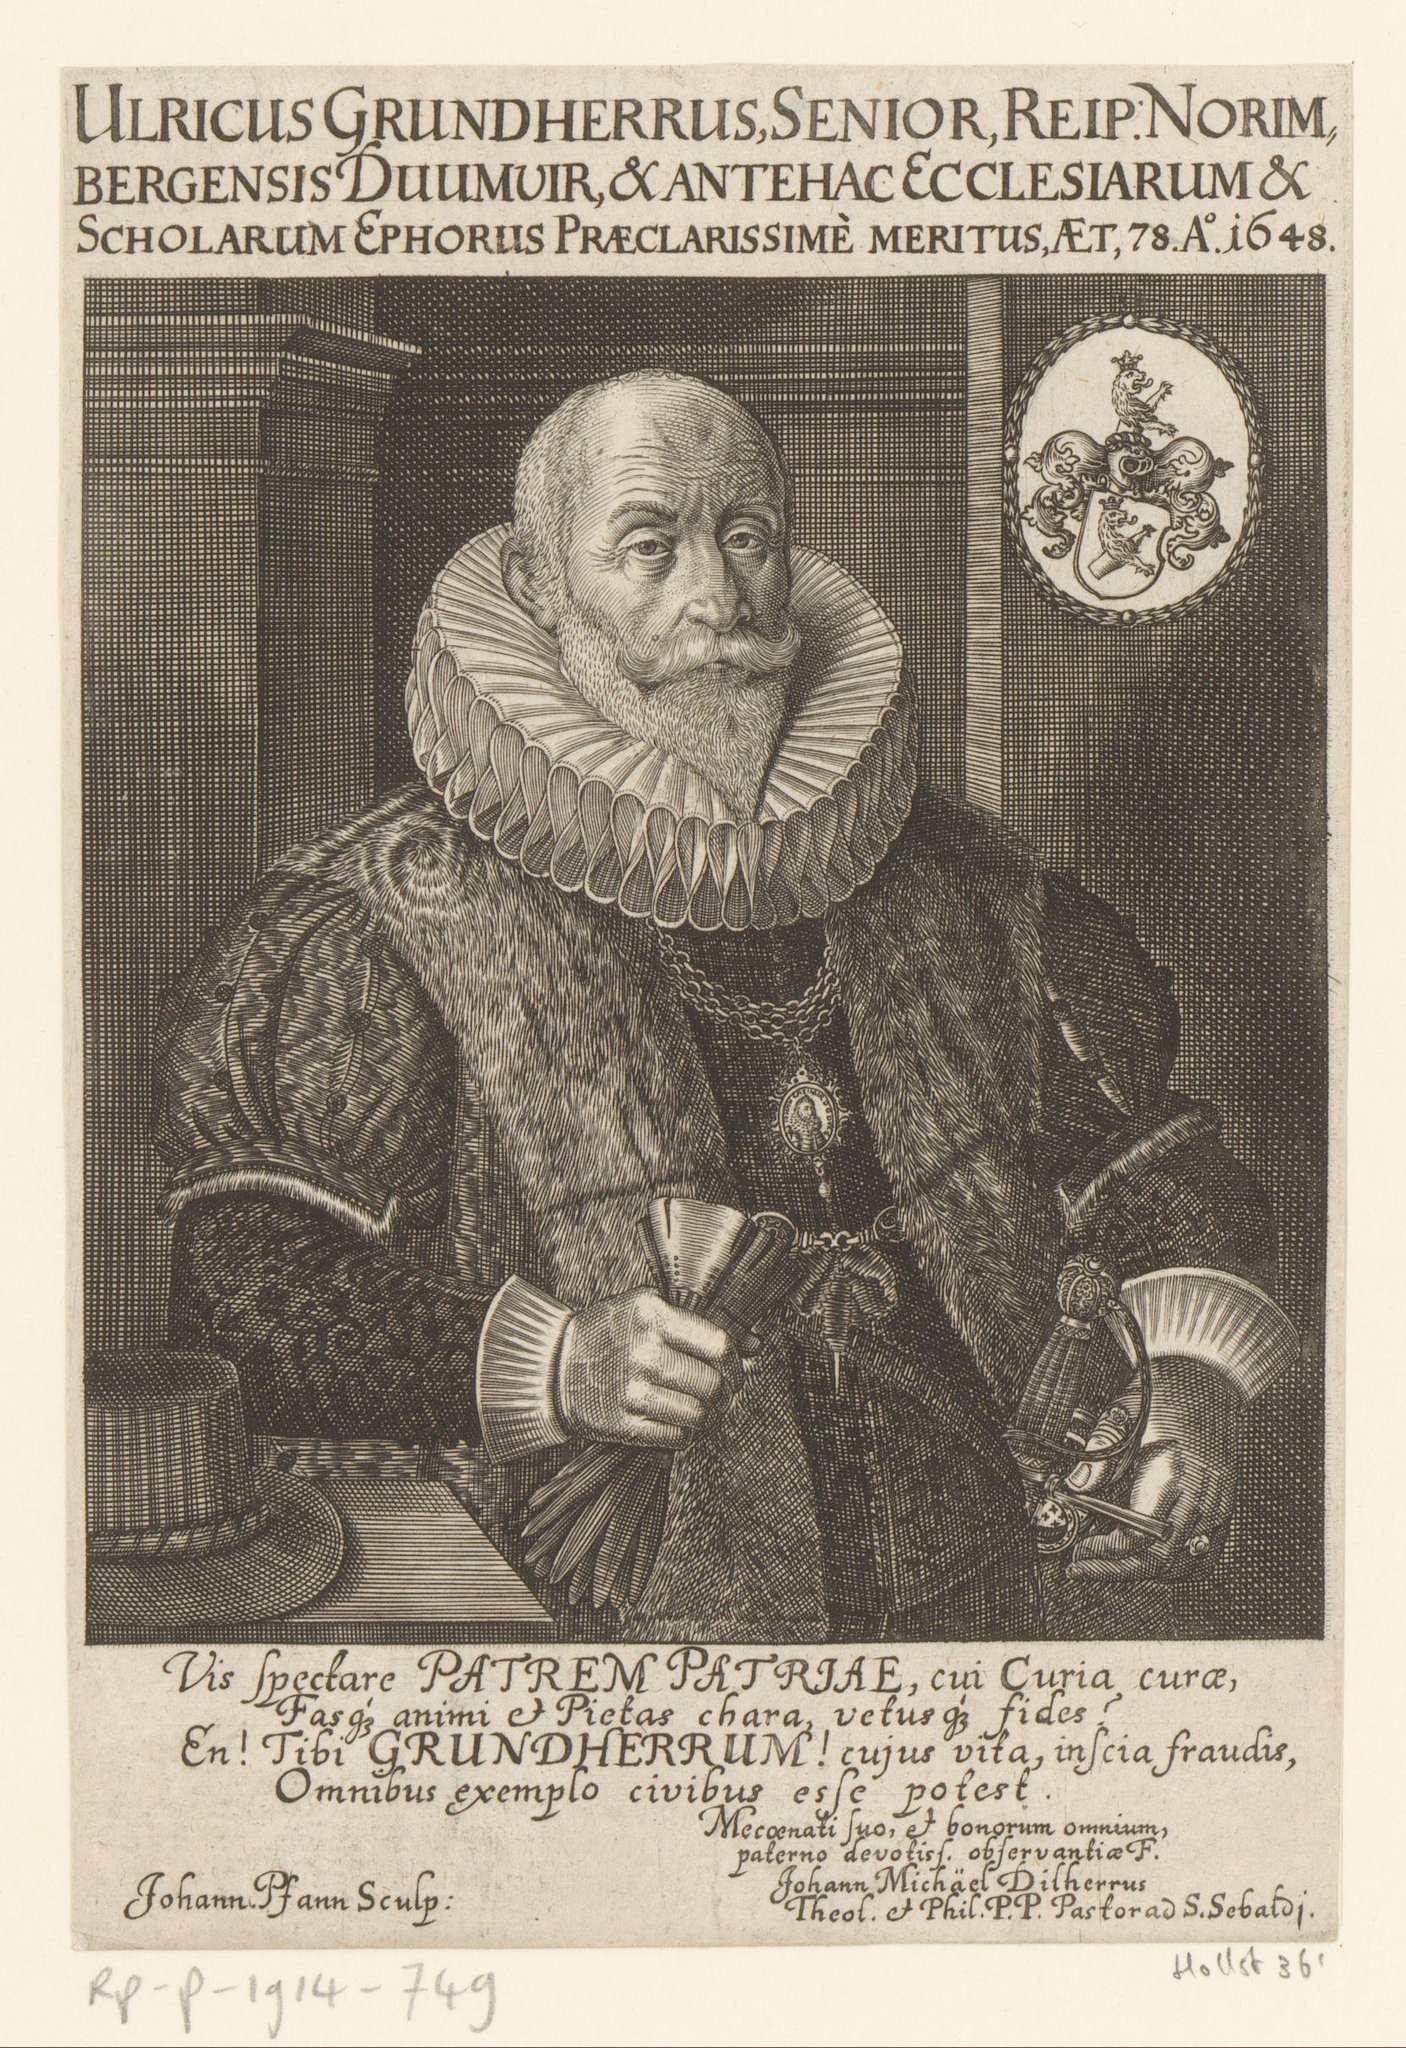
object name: print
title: Portret van Ulric Grundherr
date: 1648-1663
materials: paper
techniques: engraving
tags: mayor, gloves, mittens, etc., historical persons, hacking and thrusting weapons: sword, pendant, trinket, 'breloque', armorial bearing, heraldry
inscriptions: collector's mark: Lugt 2228